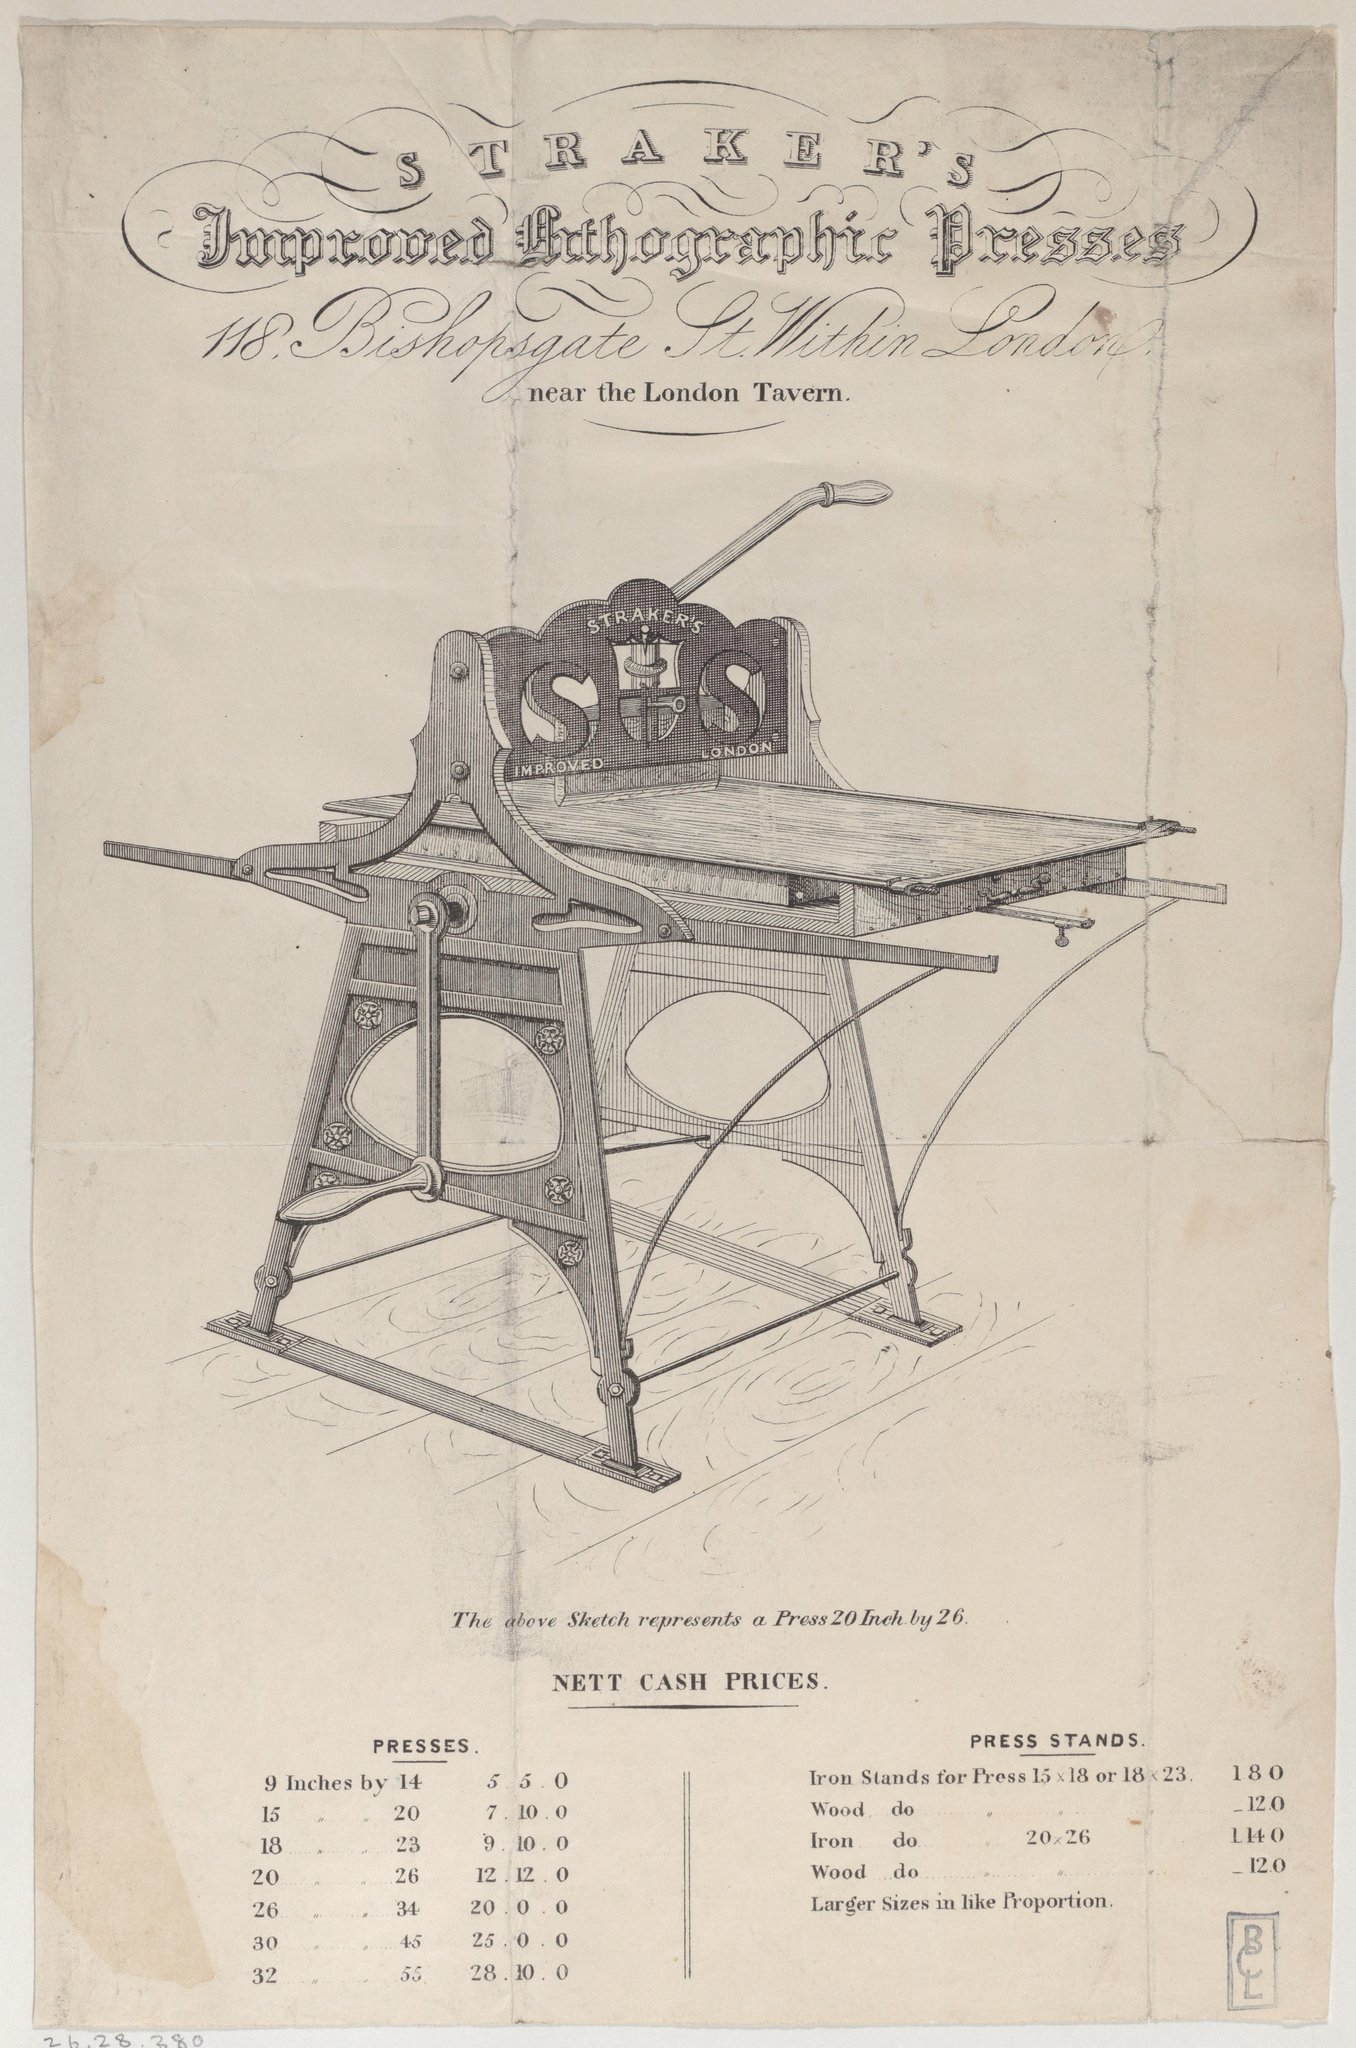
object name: print, trade card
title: Trade Card for Straker's Improved Lithographic Presses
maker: anonymous, british, 19th century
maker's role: artist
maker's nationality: british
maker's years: 1800-1900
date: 1801-1900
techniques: lithography